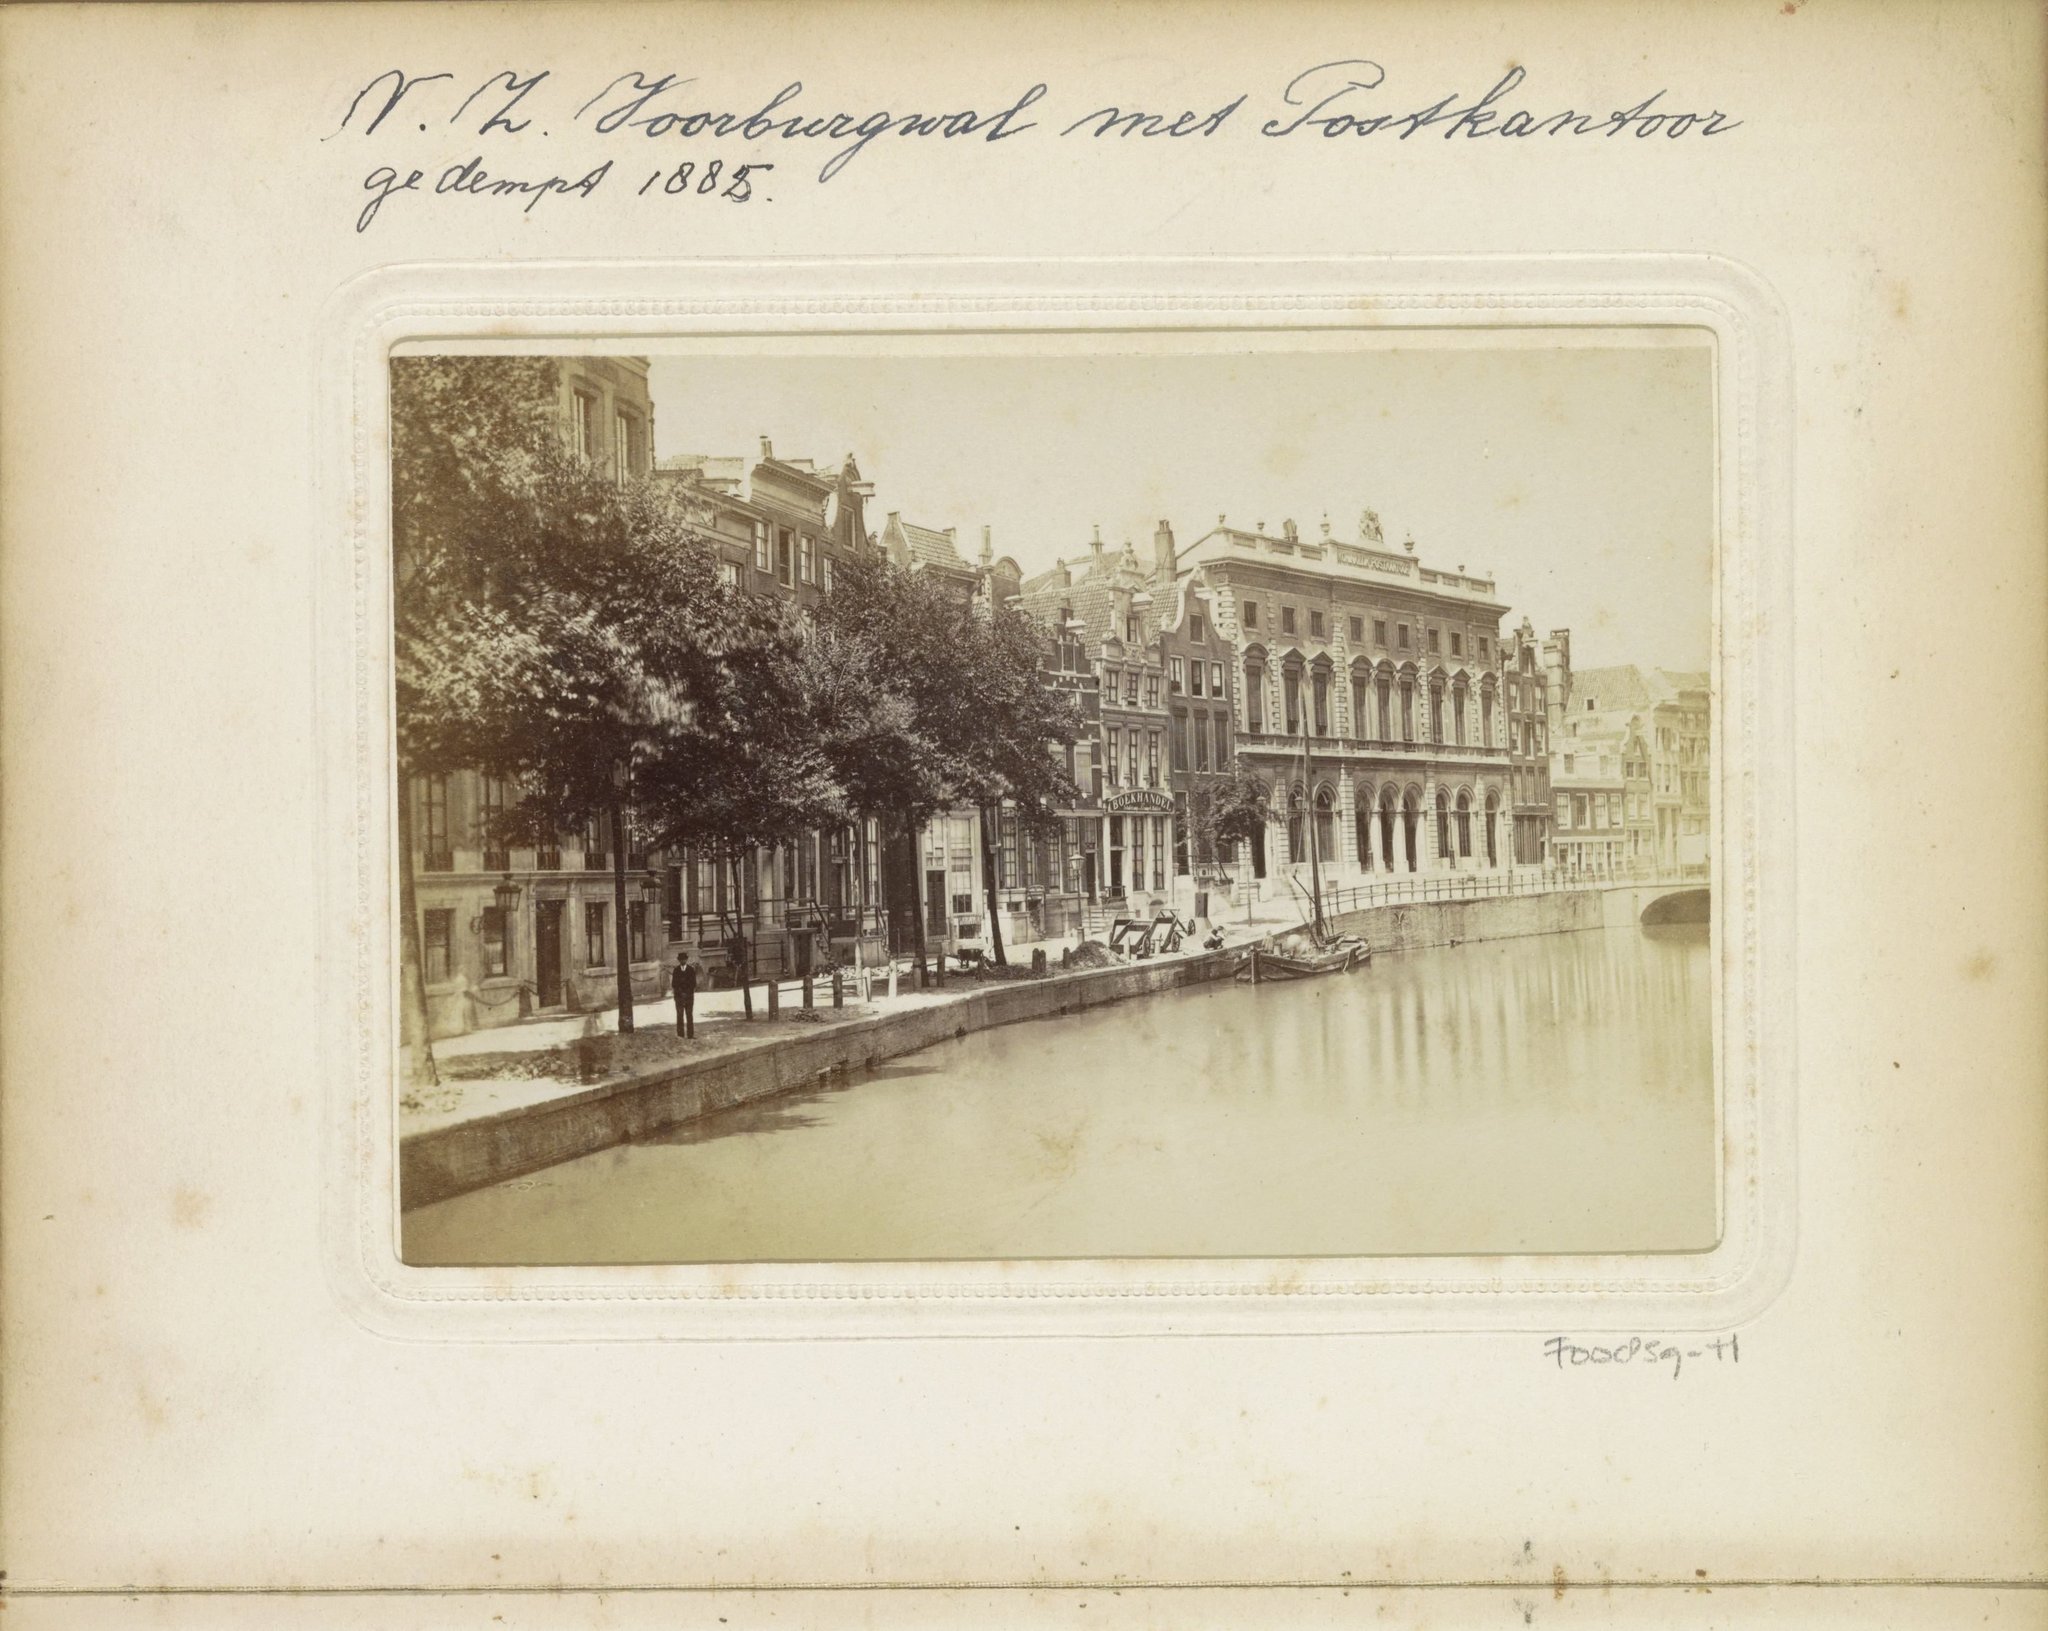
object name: cabinet photograph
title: Gezicht op de Nieuwezijds Voorburgwal met rechts het Koninklijk Postkantoor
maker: andries jager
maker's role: publisher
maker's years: 1825-1905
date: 1860-1875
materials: cardboard, paper, photographic support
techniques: albumen print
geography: amsterdam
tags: post-office, canals, waters (in city), prospect of city, town panorama, silhouette of city, amsterdam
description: Onderdeel van Fotoalbum met opnames van straten, pleinen en grachten in Amsterdam.